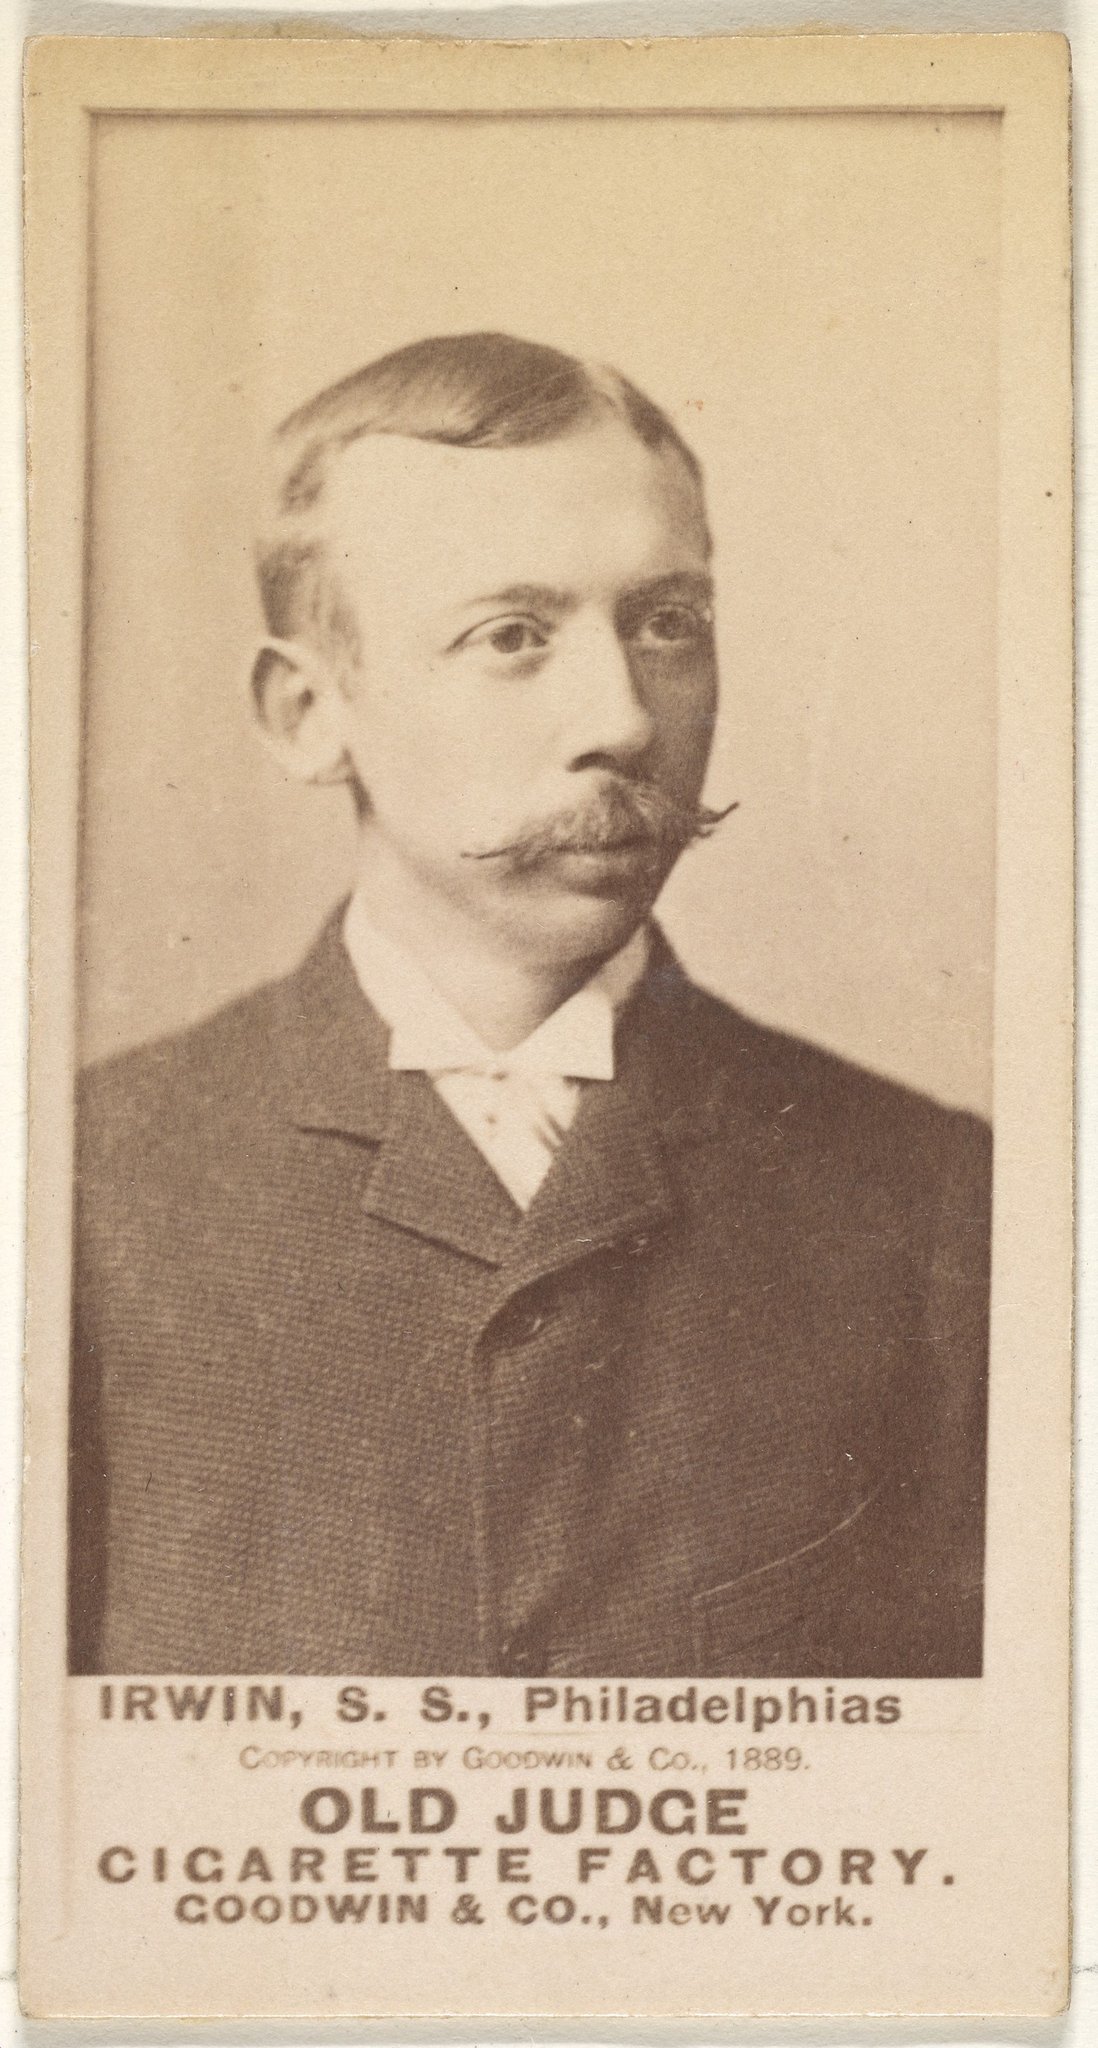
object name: baseball card, photograph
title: Arthur Albert "Doc" Irwin, Shortstop, Philadelphia, from the Old Judge series (N172) for Old Judge Cigarettes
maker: goodwin & company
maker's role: publisher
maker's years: 1850-1950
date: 1889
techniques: albumen silver print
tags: men,portraits,baseball,athletes